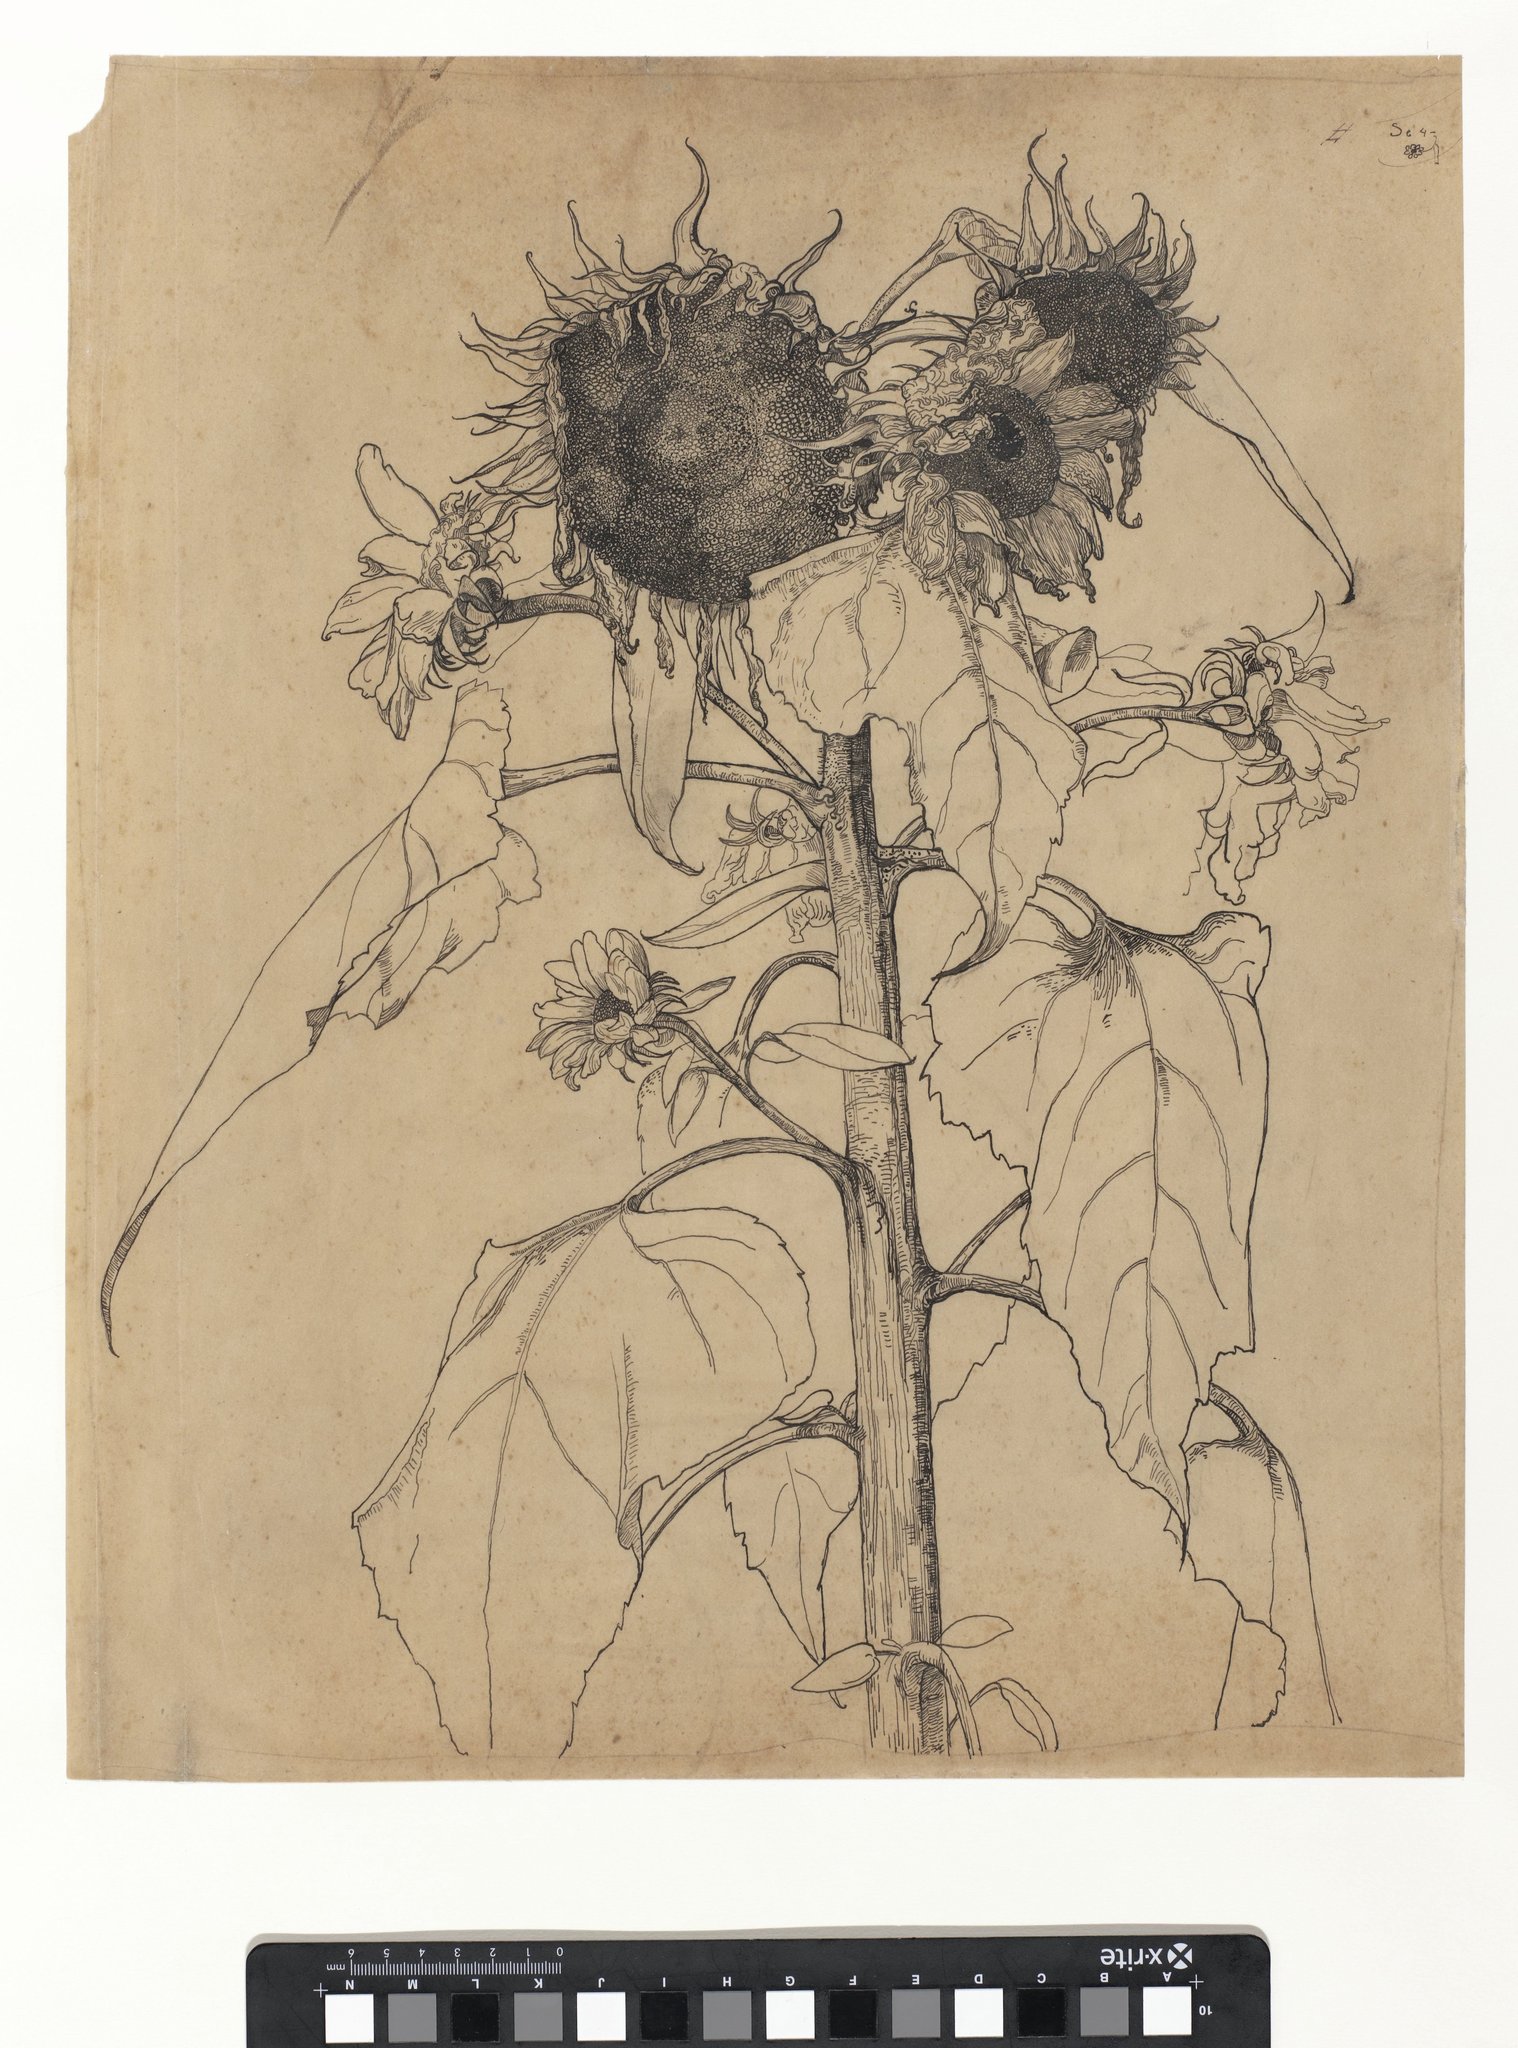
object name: drawing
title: Sunflowers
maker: richard nicolaüs roland holst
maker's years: 1868-1938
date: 1892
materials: ink, paper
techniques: pen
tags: flowers: sunflower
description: Roland Holst was one of Vincent van Gogh’s first admirers. He helped organise a Van Gogh exhibition in Amsterdam in the winter of 1892-1893. For the accompanying catalogue he designed a cover illustrating a dying sunflower before the setting sun. Perhaps somewhat less sentimental is this detailed, forcefully drawn study of an overblown sunflower.